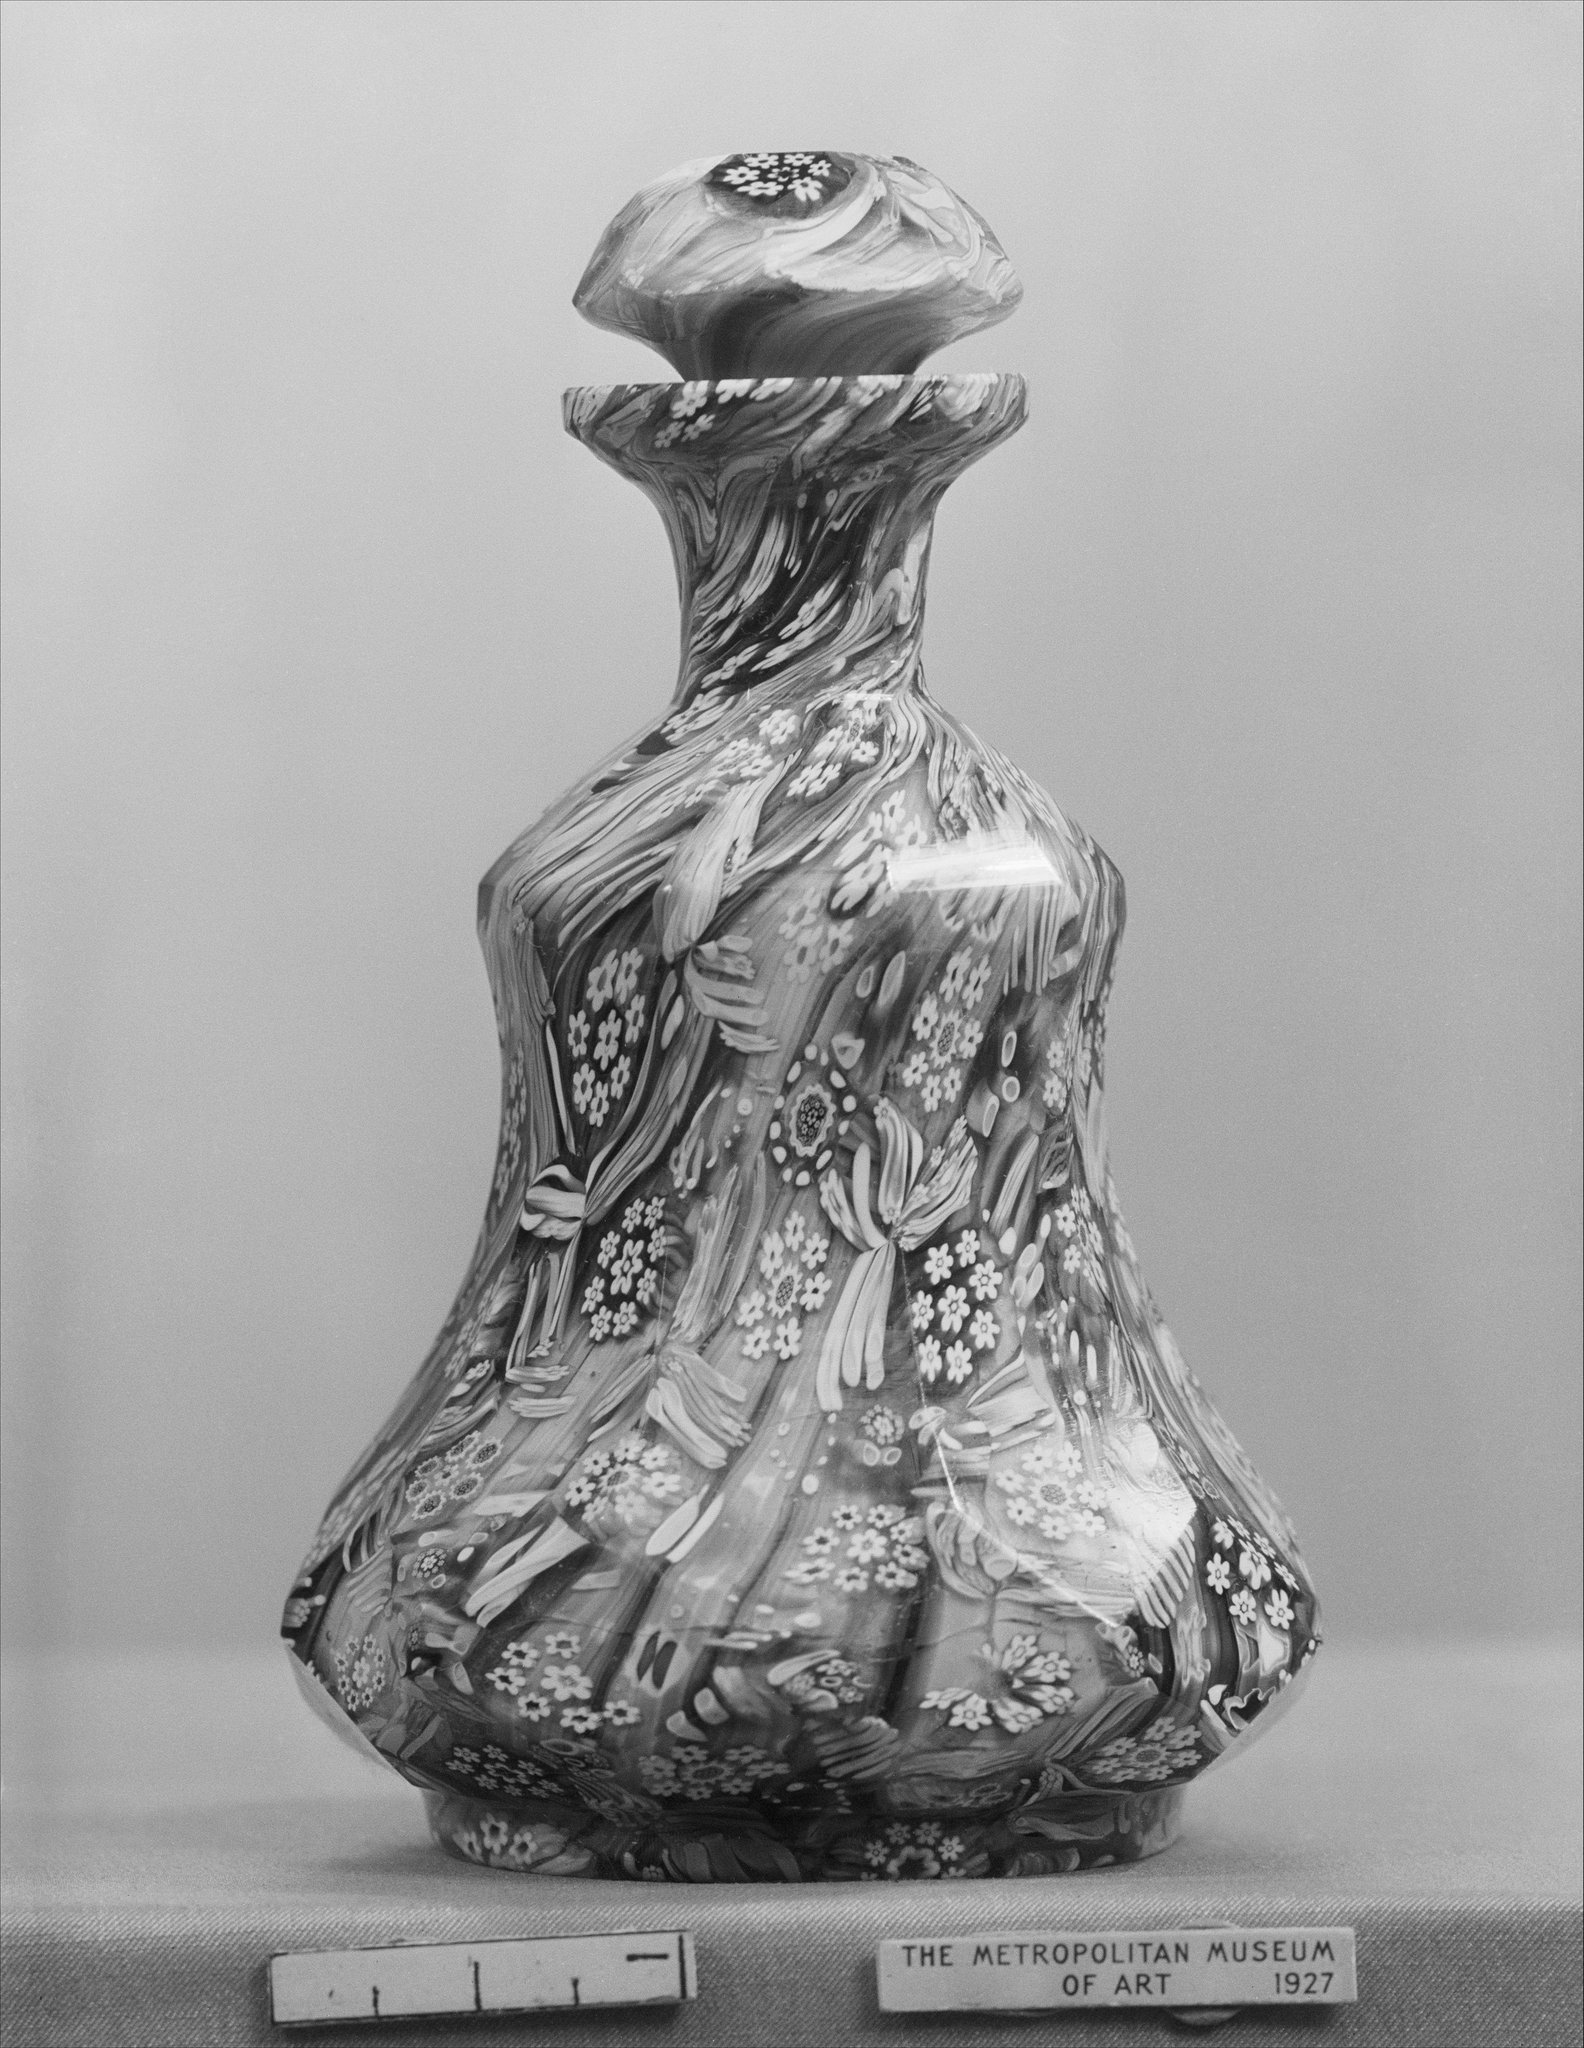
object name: bottle with stopper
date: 1835-1840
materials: glass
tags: flowers